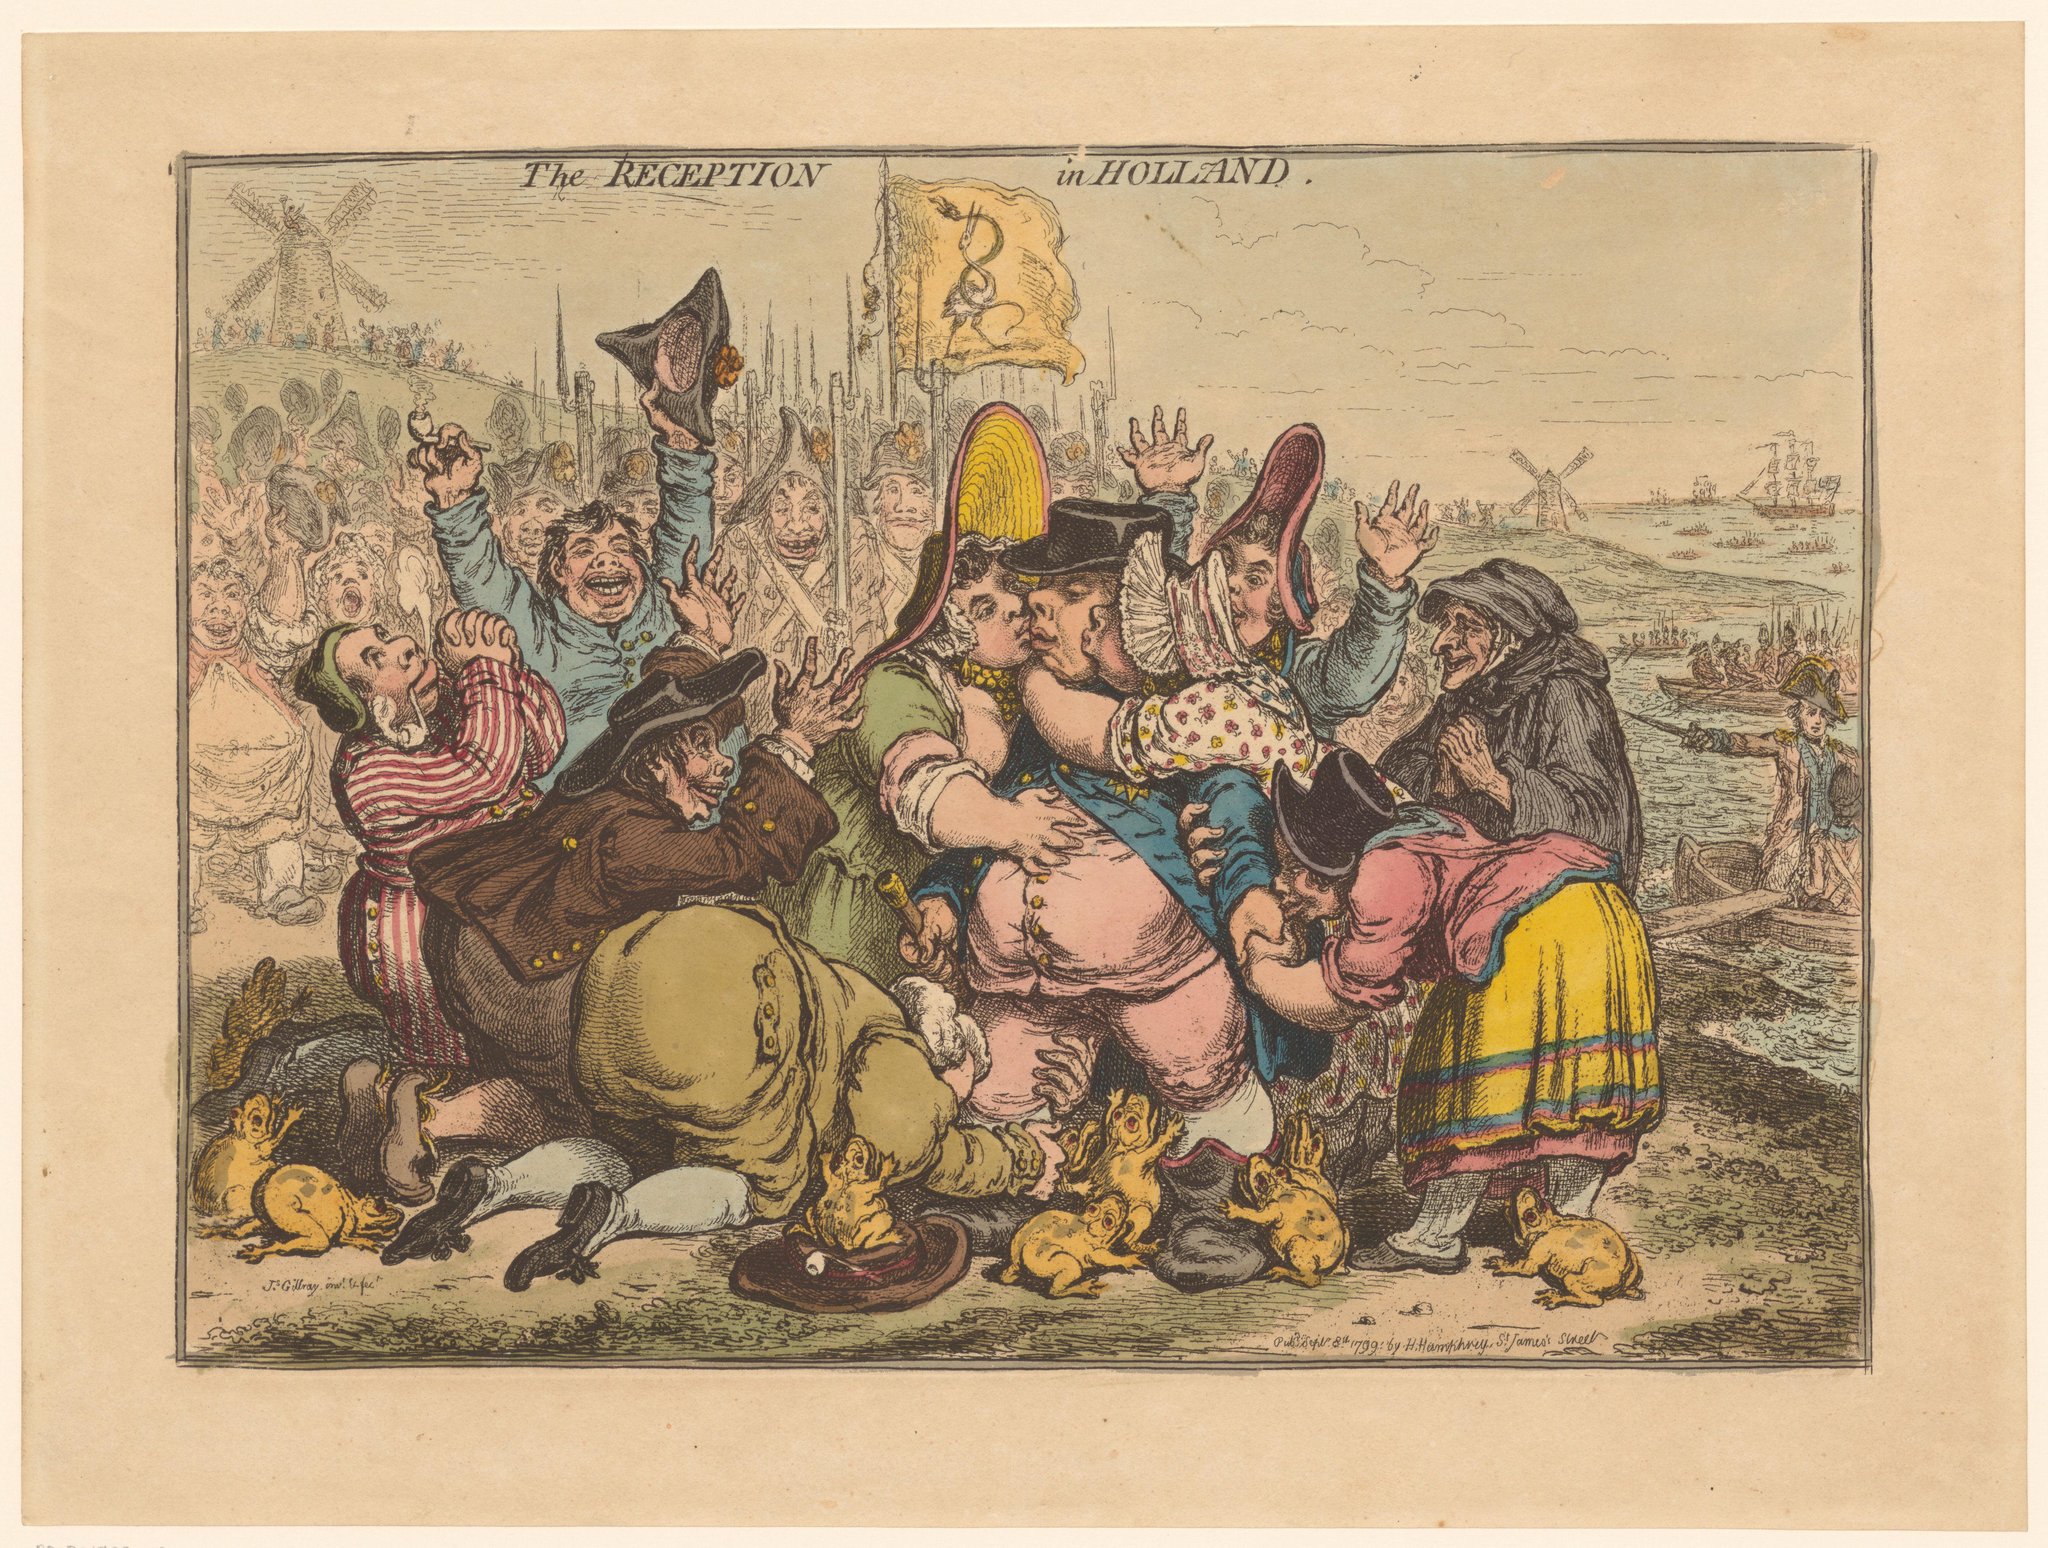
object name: cartoon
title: Man wordt door een Hollandse menigte begroet en gekust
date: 1799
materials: paper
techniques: etching, hand coloring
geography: london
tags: william v (prince of orange), tailless amphibians: frog, triumphal entry and public reception, pageant, 'entrée solennelle', 'joyeuse entrée', political caricatures and satires, the hague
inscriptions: collector's mark: Lugt 2233, collector's mark: Lugt 2228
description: De aankomst van Willem V, prins van Oranje-Nassau. De kikkers aan de voeten van de prins representeren de Hollandse burgers. Op de vlag staan een ooievaar en slang afgebeeld; het wapen van de stad Den Haag. Aan de kust arriveren de Britse troepen. Satire op de Brits-Russische invasie in 1799.